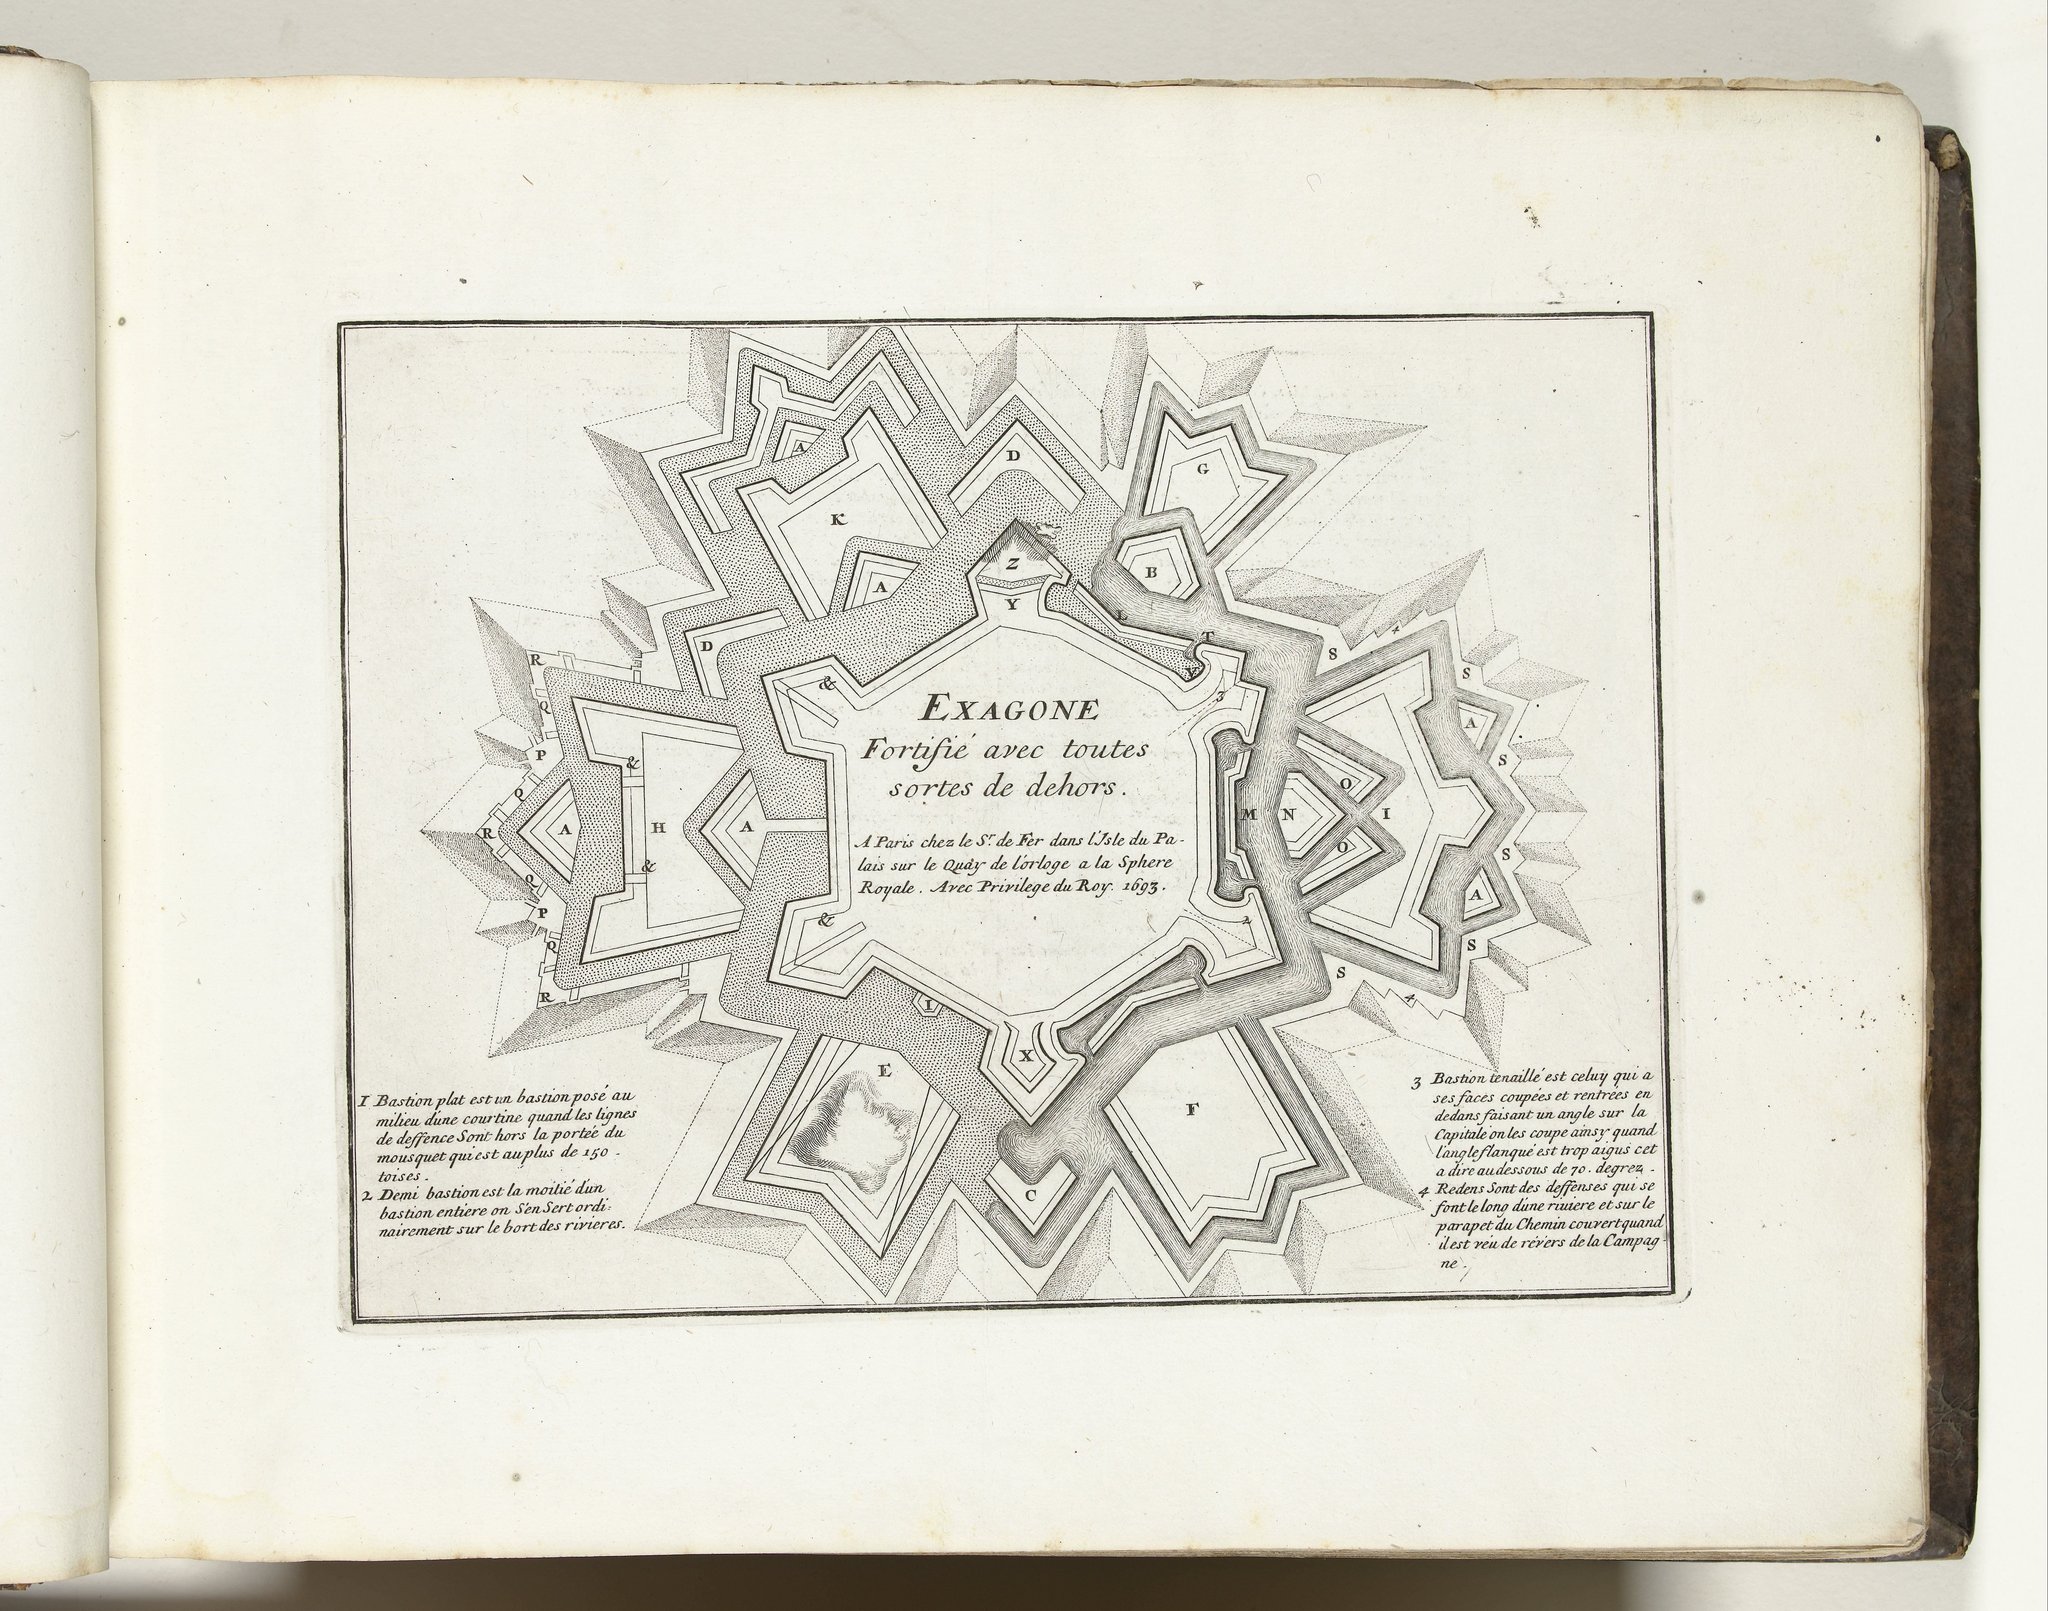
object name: print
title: Exagone Fortifié avec toutes sortes de dehors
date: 1693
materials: paper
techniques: etching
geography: paris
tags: fortifications, military engineering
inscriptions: date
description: Vijfde plaat met de toepassing van het geometrische figuur van de zeshoek in de vestingbouw. Onderdeel van het eerste deel (1693) van het prentwerk waarin gebundeld zijn de acht delen van Les forces de l'Europe uitgegeven tussen 1693-1697. Het prentwerk bestaat uit 175 platen met plannen (afkomstig van Sébastien Le Prestre, Seigneur de Vauban) van vermaarde sterke steden en vestingen in de Negenjarige Oorlog. Titel in het Frans.